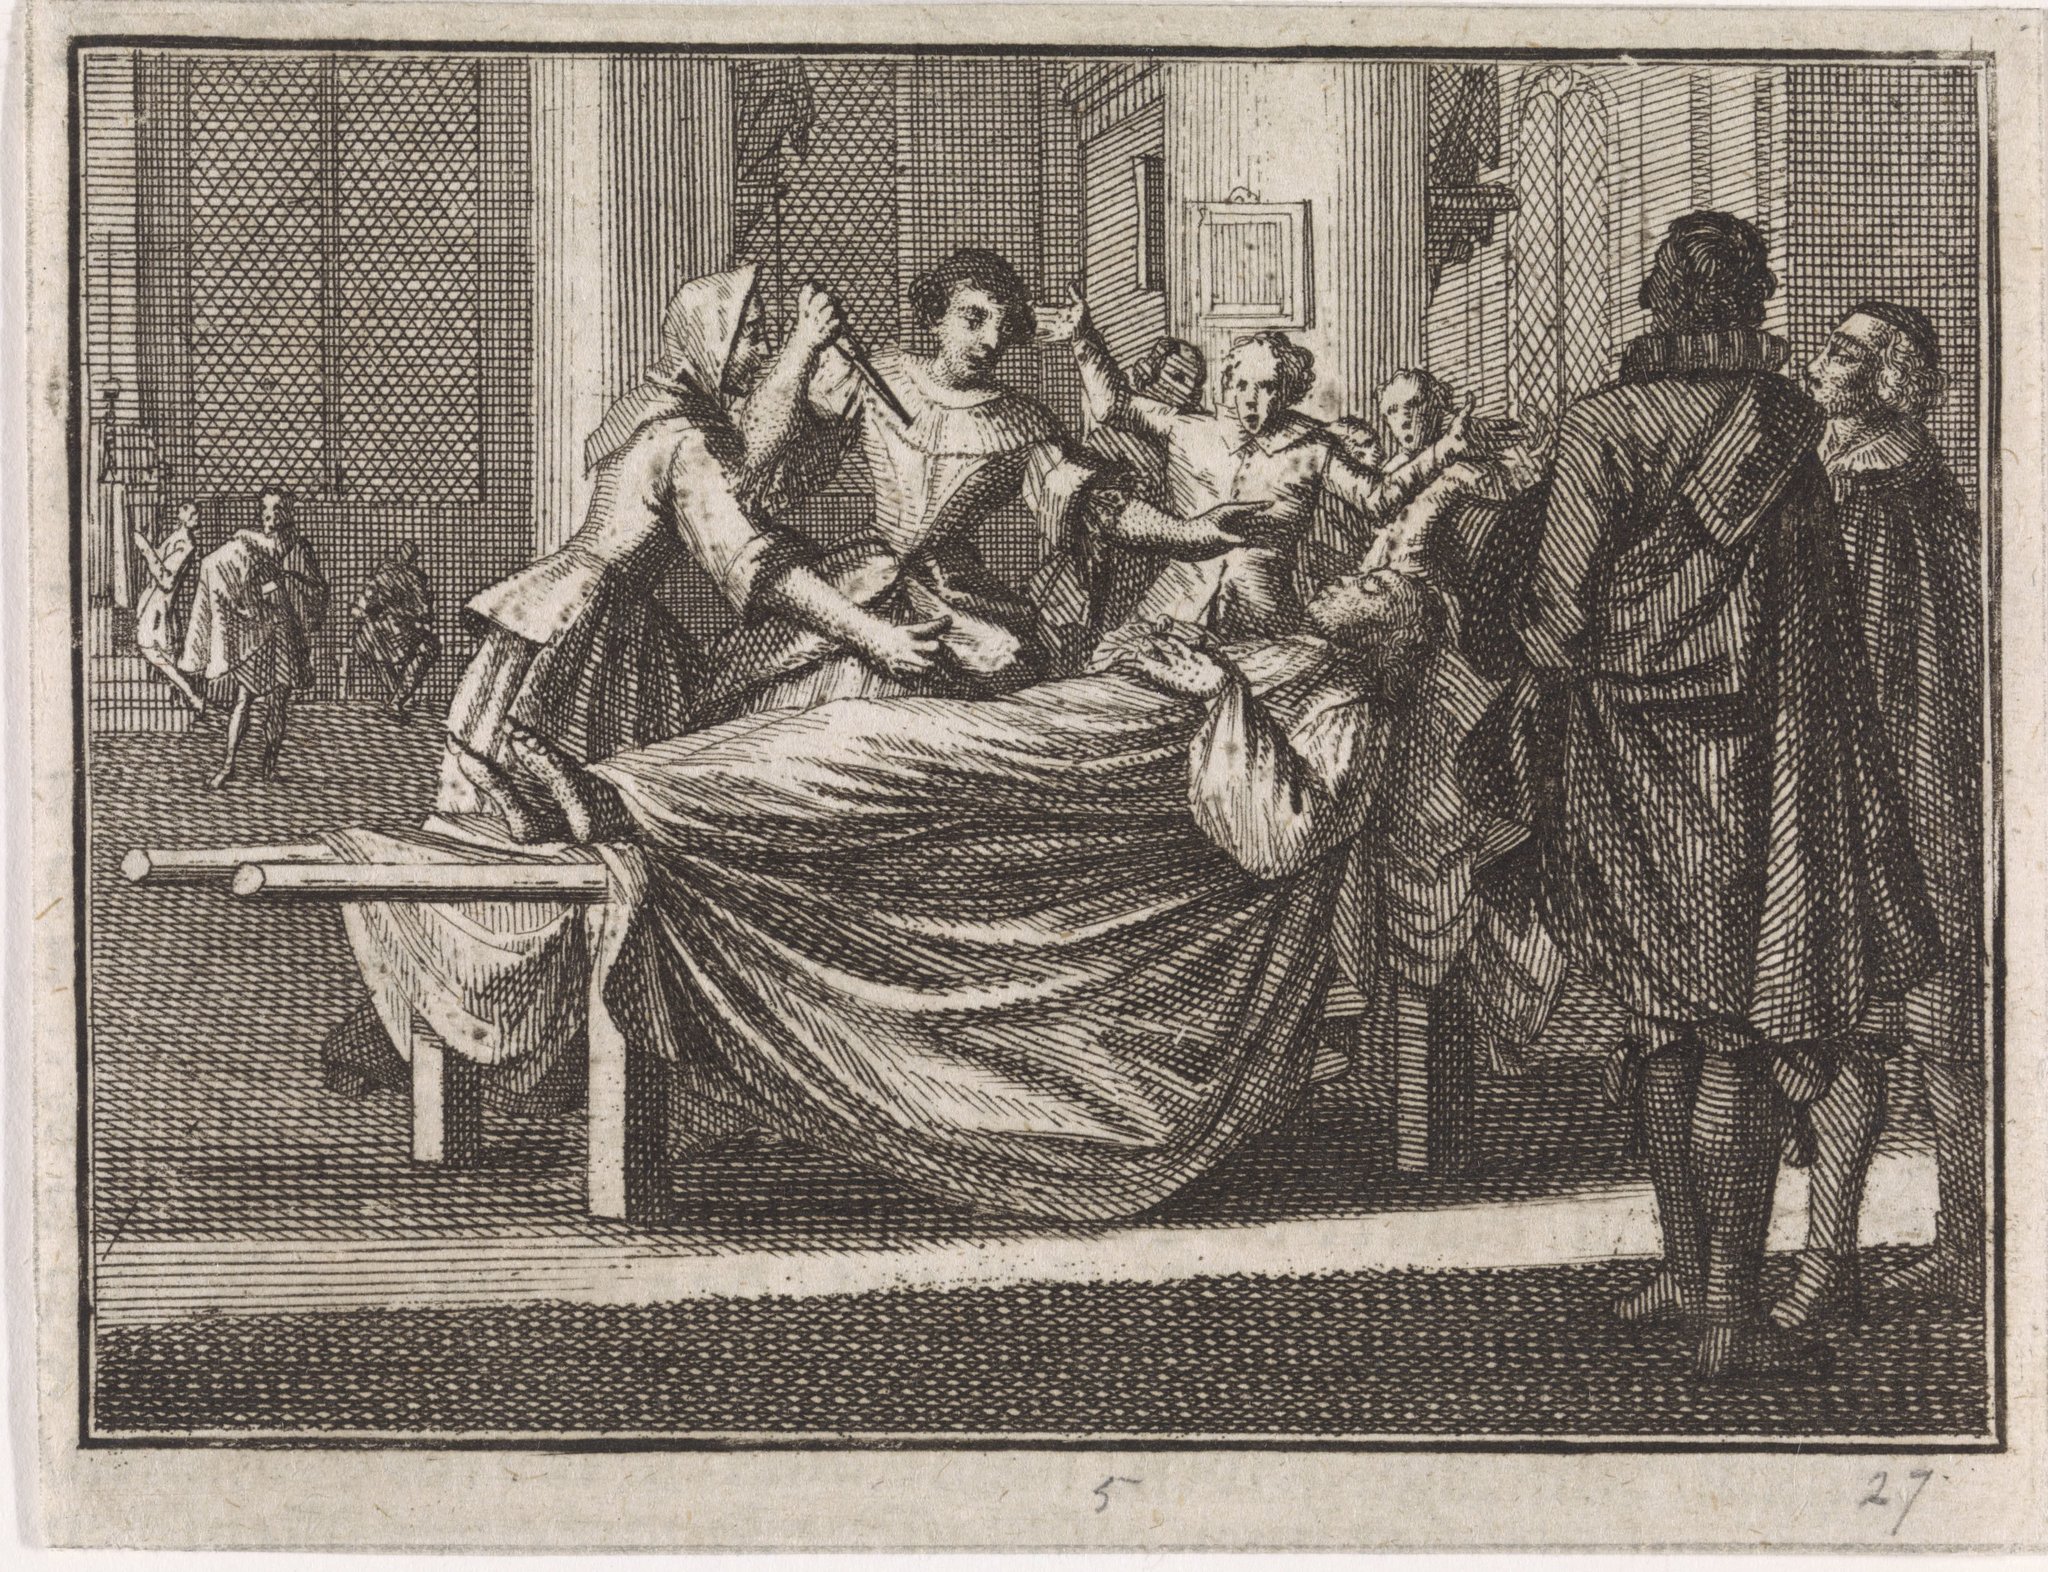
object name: book illustration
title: Minnares van een dode man doorsteekt zichzelf met een dolk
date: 1704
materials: paper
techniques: etching, letterpress printing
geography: nuremberg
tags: mourning the dead, suicide out of despair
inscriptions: collector's mark: Lugt 2228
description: Illustratie uit: Abraham a Sancta Clara. Heilsames Gemisch Gemasch, das ist: Allerley seltsame und verwunderliche Geschichten (...). Neurenberg: Christoph Weigel, 1704, p. 27, p. 27.